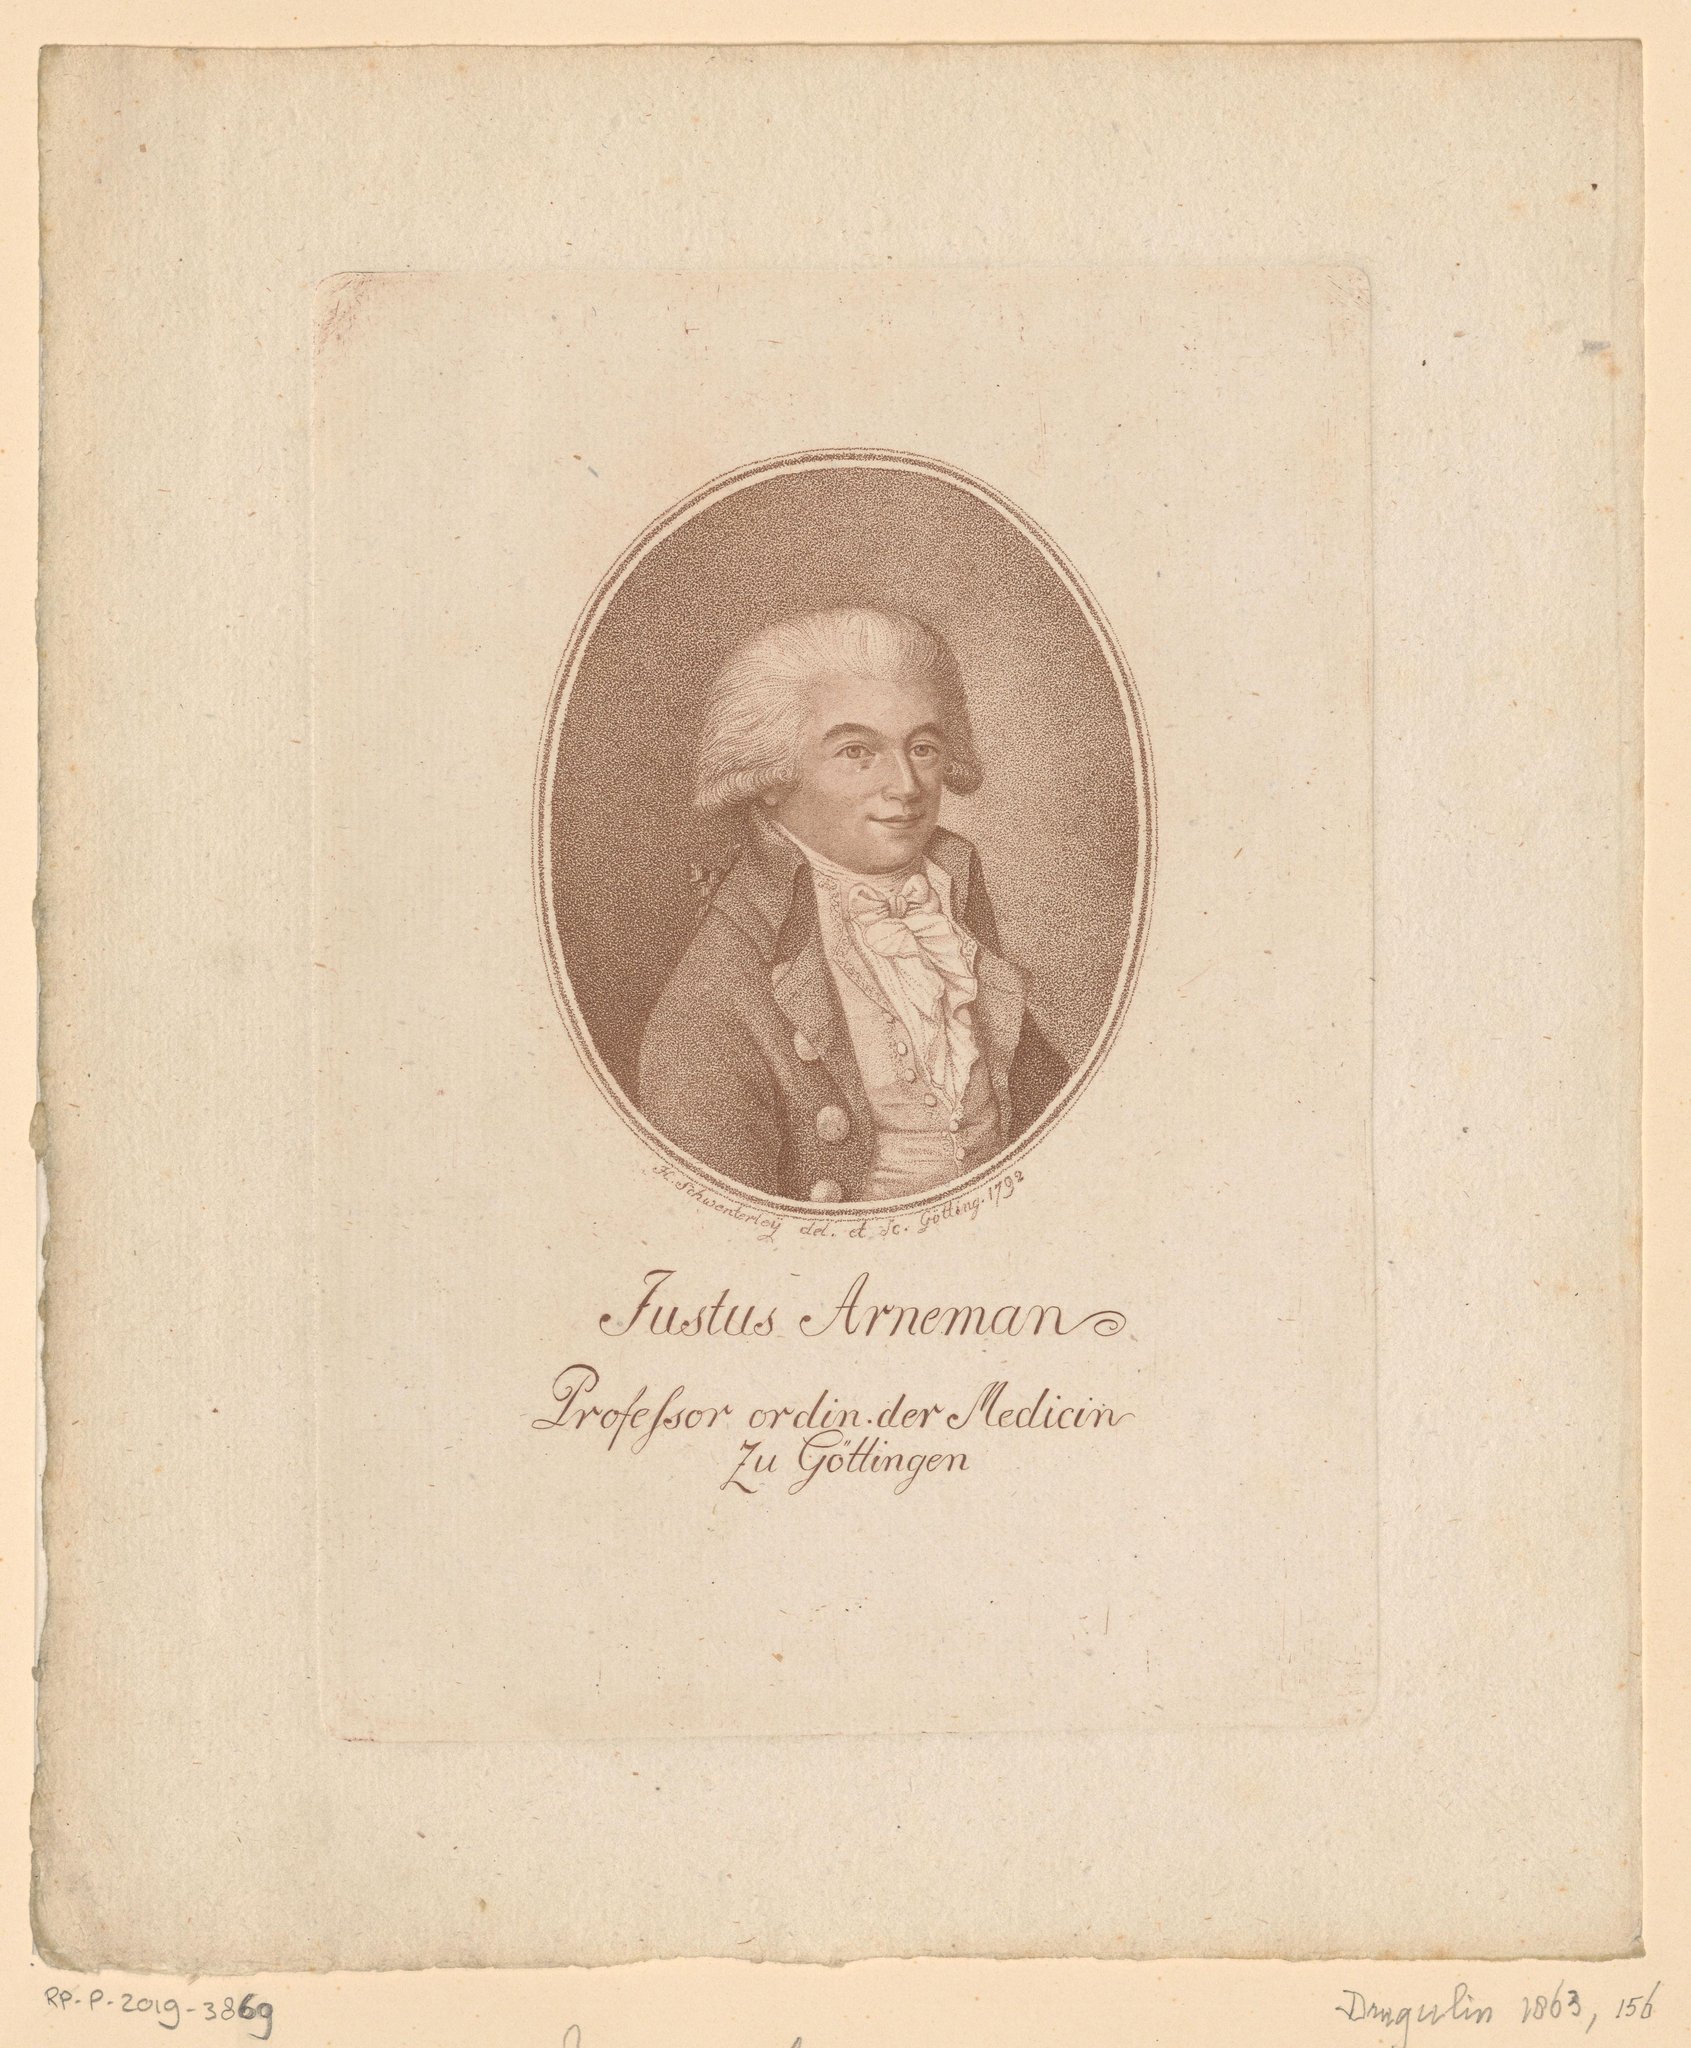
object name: print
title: Portret van Justus Arnemann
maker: heinrich schwenterley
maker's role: print maker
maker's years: 1749-1815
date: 1792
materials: paper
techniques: etching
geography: gottingen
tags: historical persons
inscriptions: date